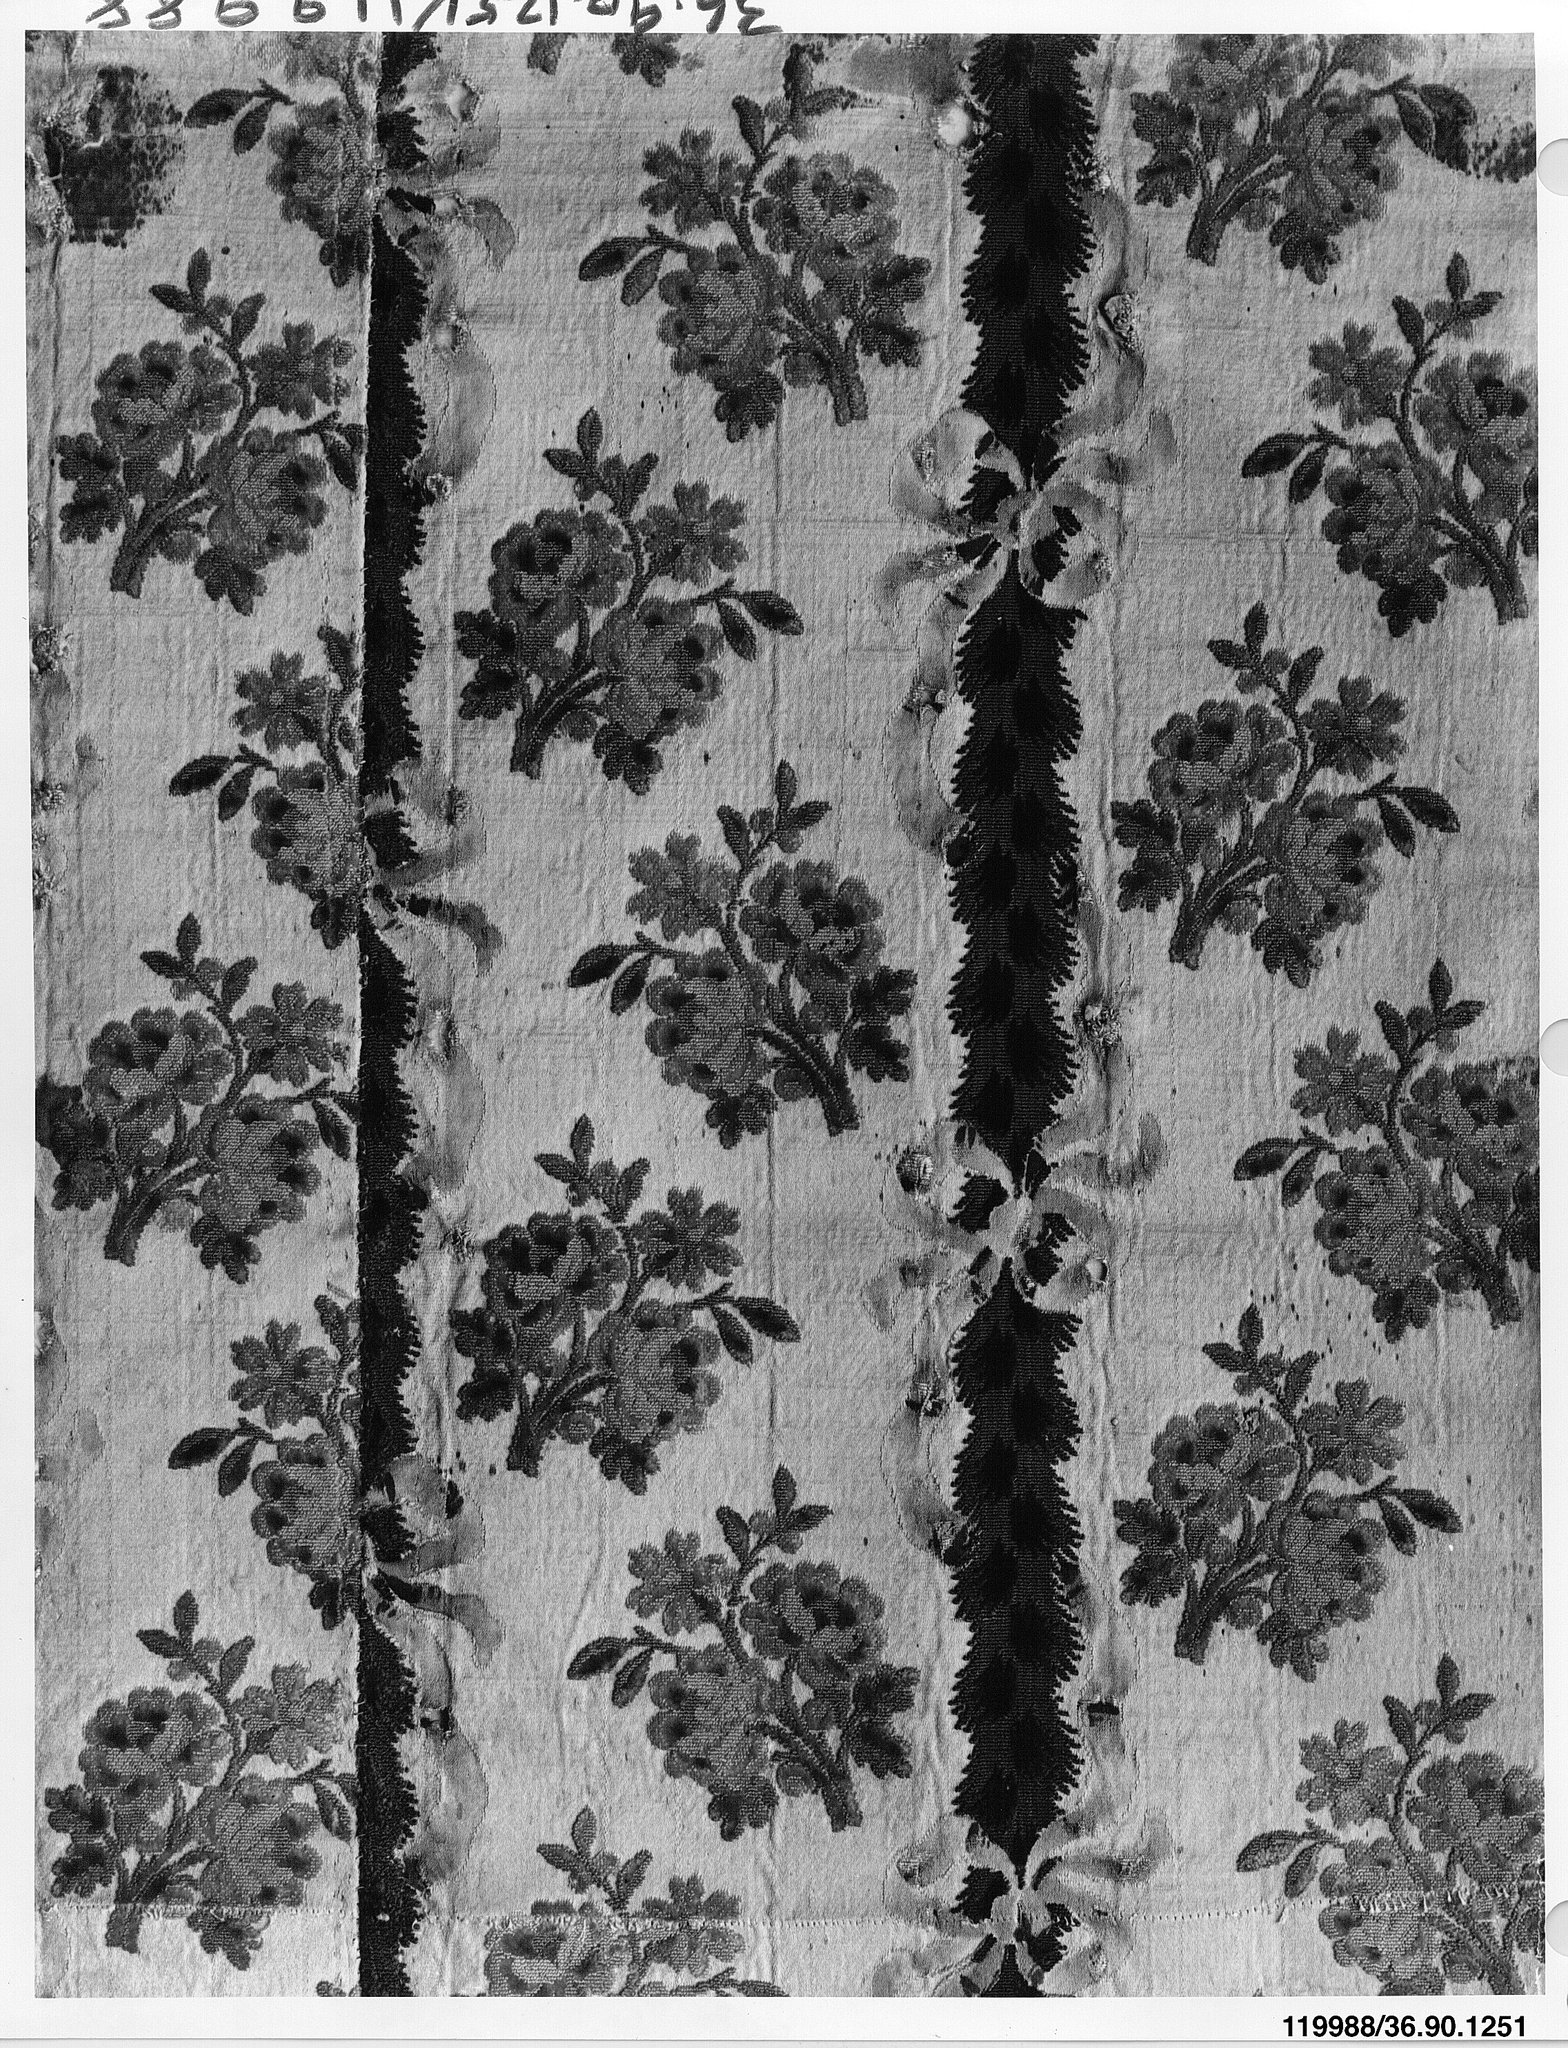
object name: piece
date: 1701-1800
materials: silk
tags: flowers,leaves